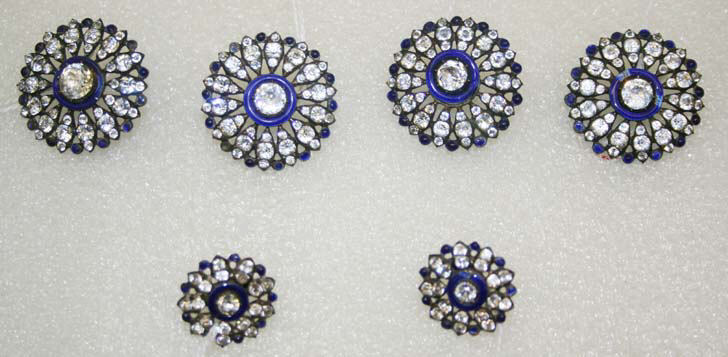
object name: button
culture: french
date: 1785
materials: enamel, metal